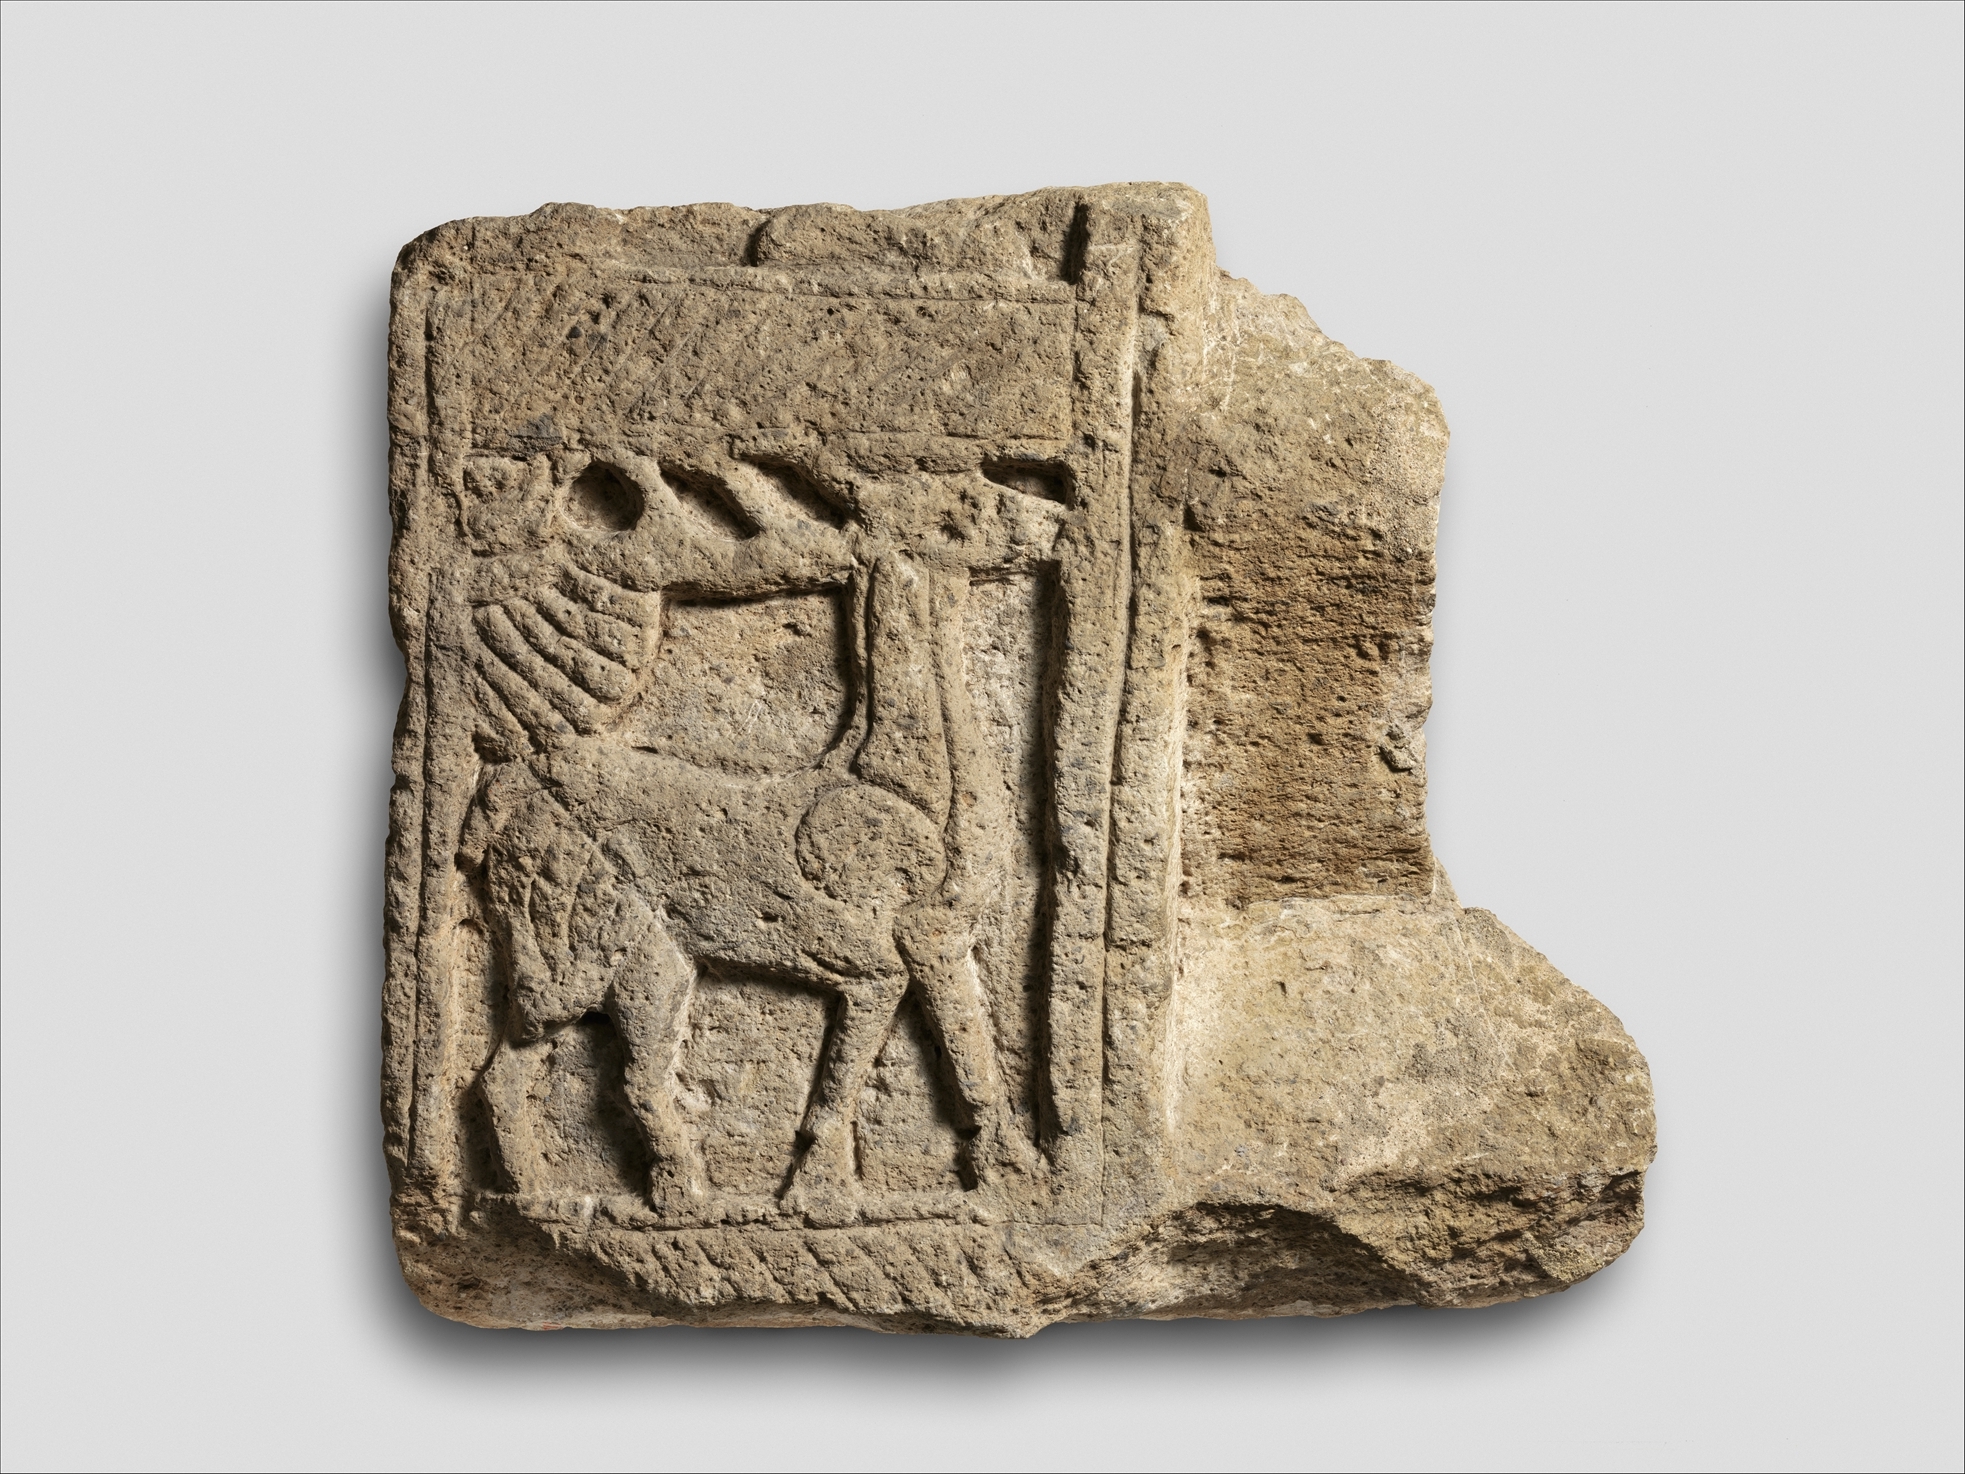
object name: relief fragment with a stag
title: Nenfro tomb-slab fragment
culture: etruscan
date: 600-550 BCE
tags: animals